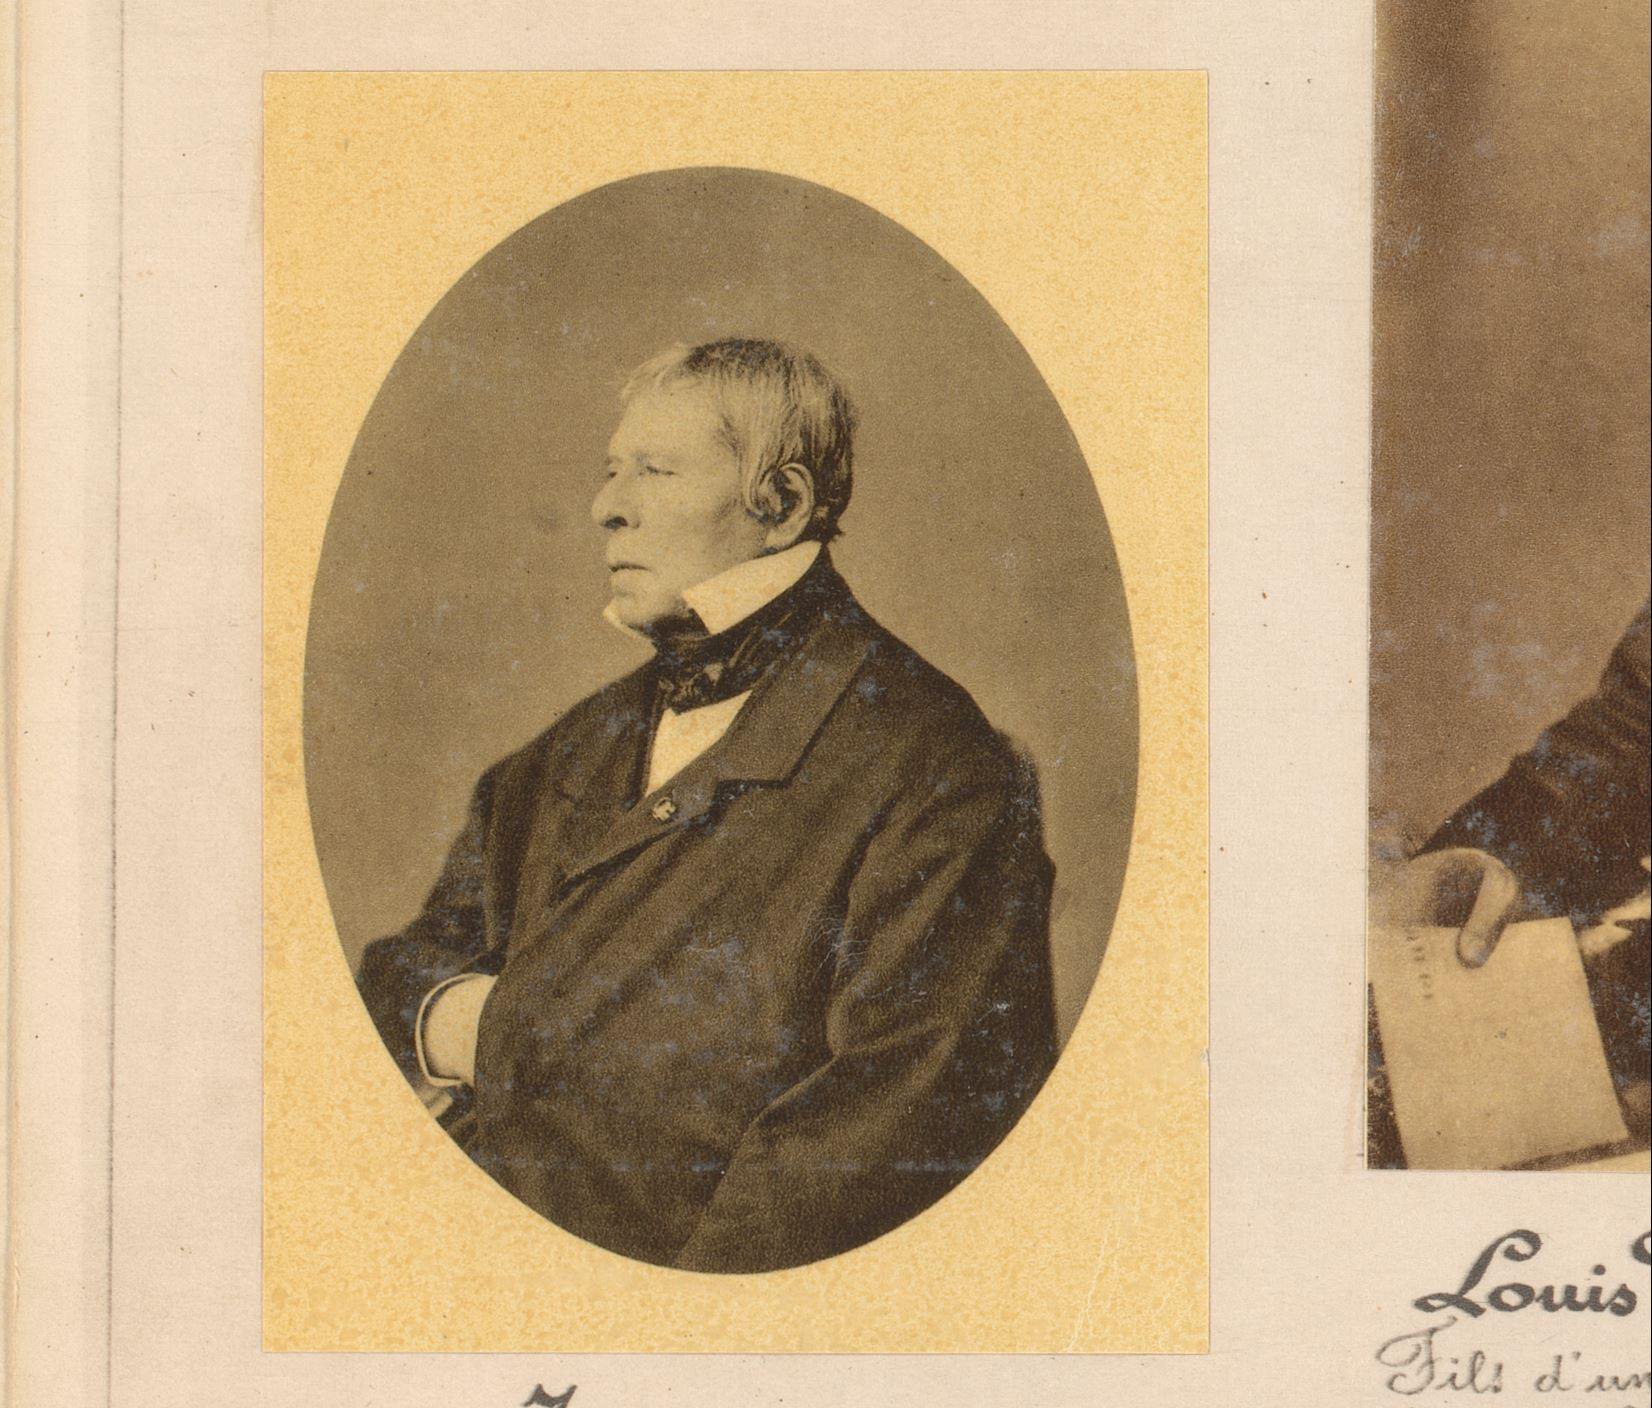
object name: album leaf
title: Ingres (1841)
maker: Anonymous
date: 1841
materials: paper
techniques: rotogravure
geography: france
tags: paris, print maker, draughtsman, jean auguste dominique ingres, portrait, self-portrait of painter, france